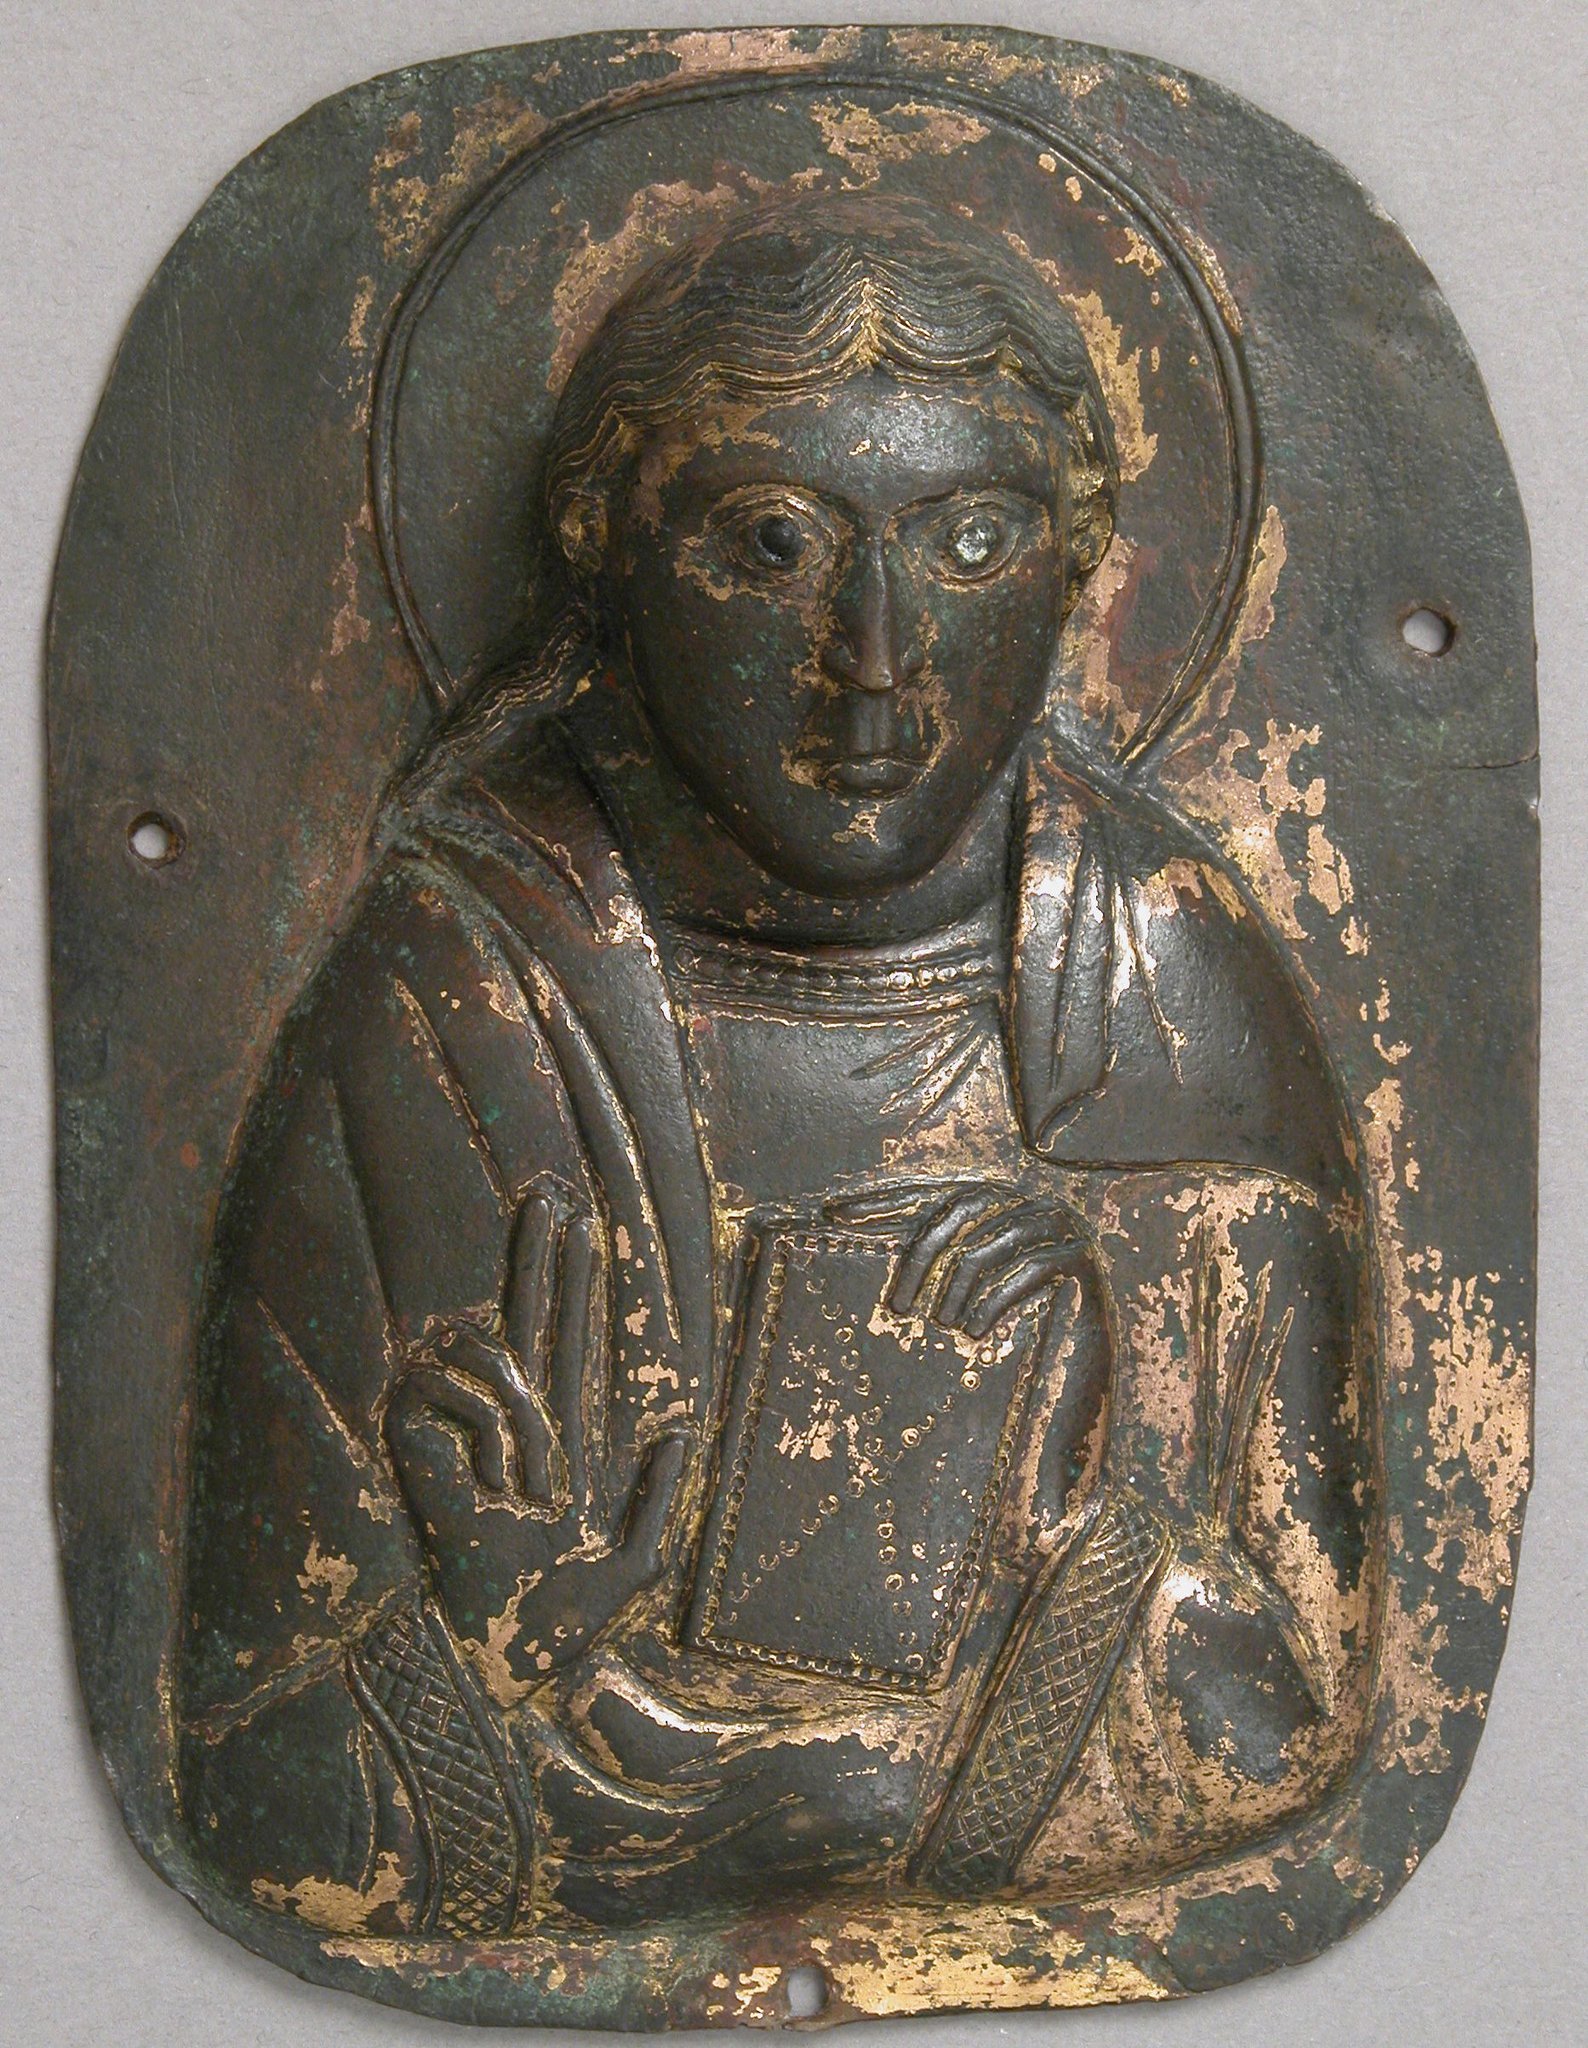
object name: plaque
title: Bust of an Apostle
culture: south netherlandish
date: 1120-1130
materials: copper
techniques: gilding